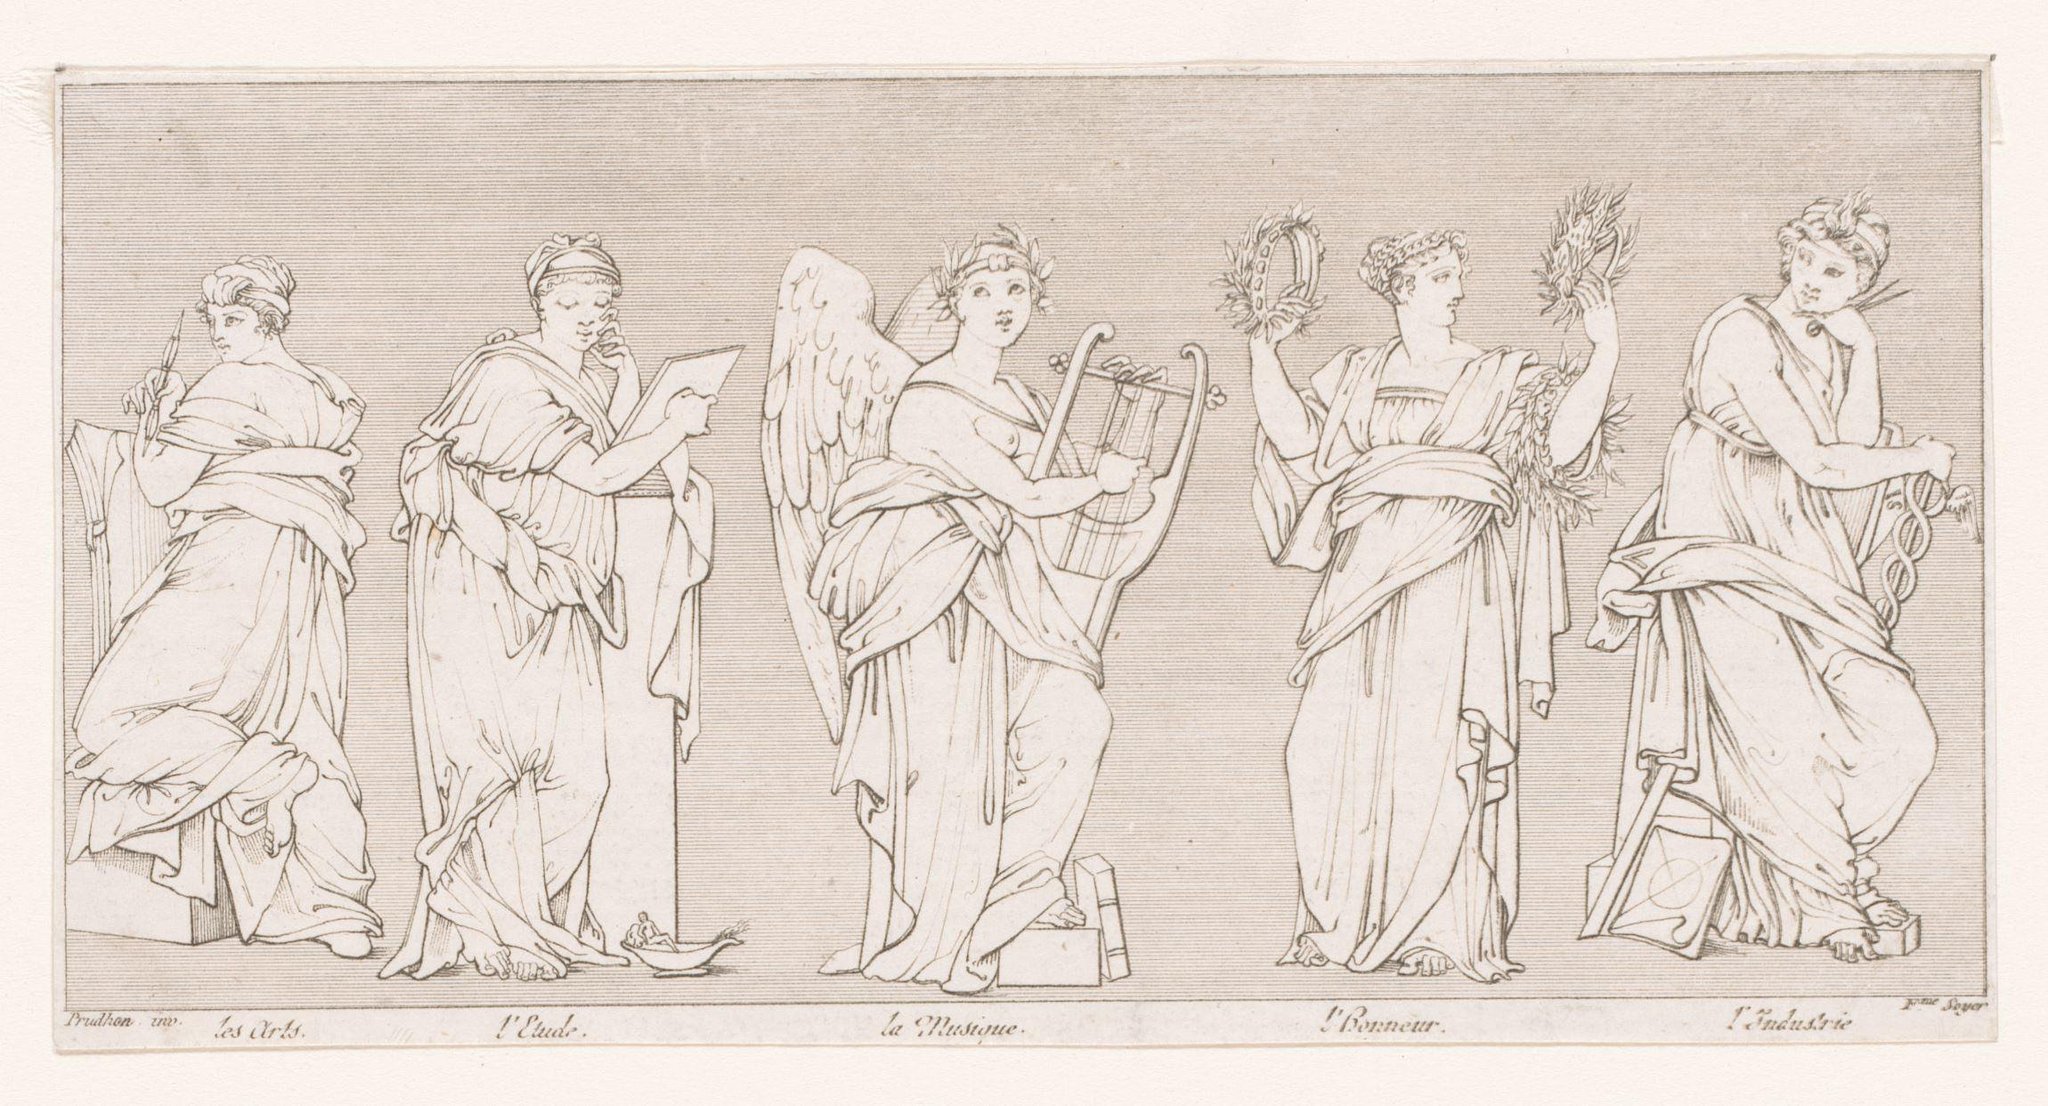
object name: book illustration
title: Vijf muzen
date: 1810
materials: paper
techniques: etching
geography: paris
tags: 'musica', symbolic representations, allegories and emblems ~ music; 'musica'(ripa), symbolic representations, allegories and emblems ~ art; 'arte' (ripa), fame; 'fama', 'fama buona', 'fama chiara' (ripa), industries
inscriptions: collector's mark: Lugt 2228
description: Prent uit: Goulet, Nicolas. Fêtes a l'occasion du mariage de S. M. Napoléon, empereur des Français (...). Parijs: L. Ch. Soyer, 1810. Prent naar de figuren die als decoratie gebruikt zijn in het stadhuis, tijdens het huwelijk van Napoleon I Bonaparte en Marie Louise van Oostenrijk in 1810.